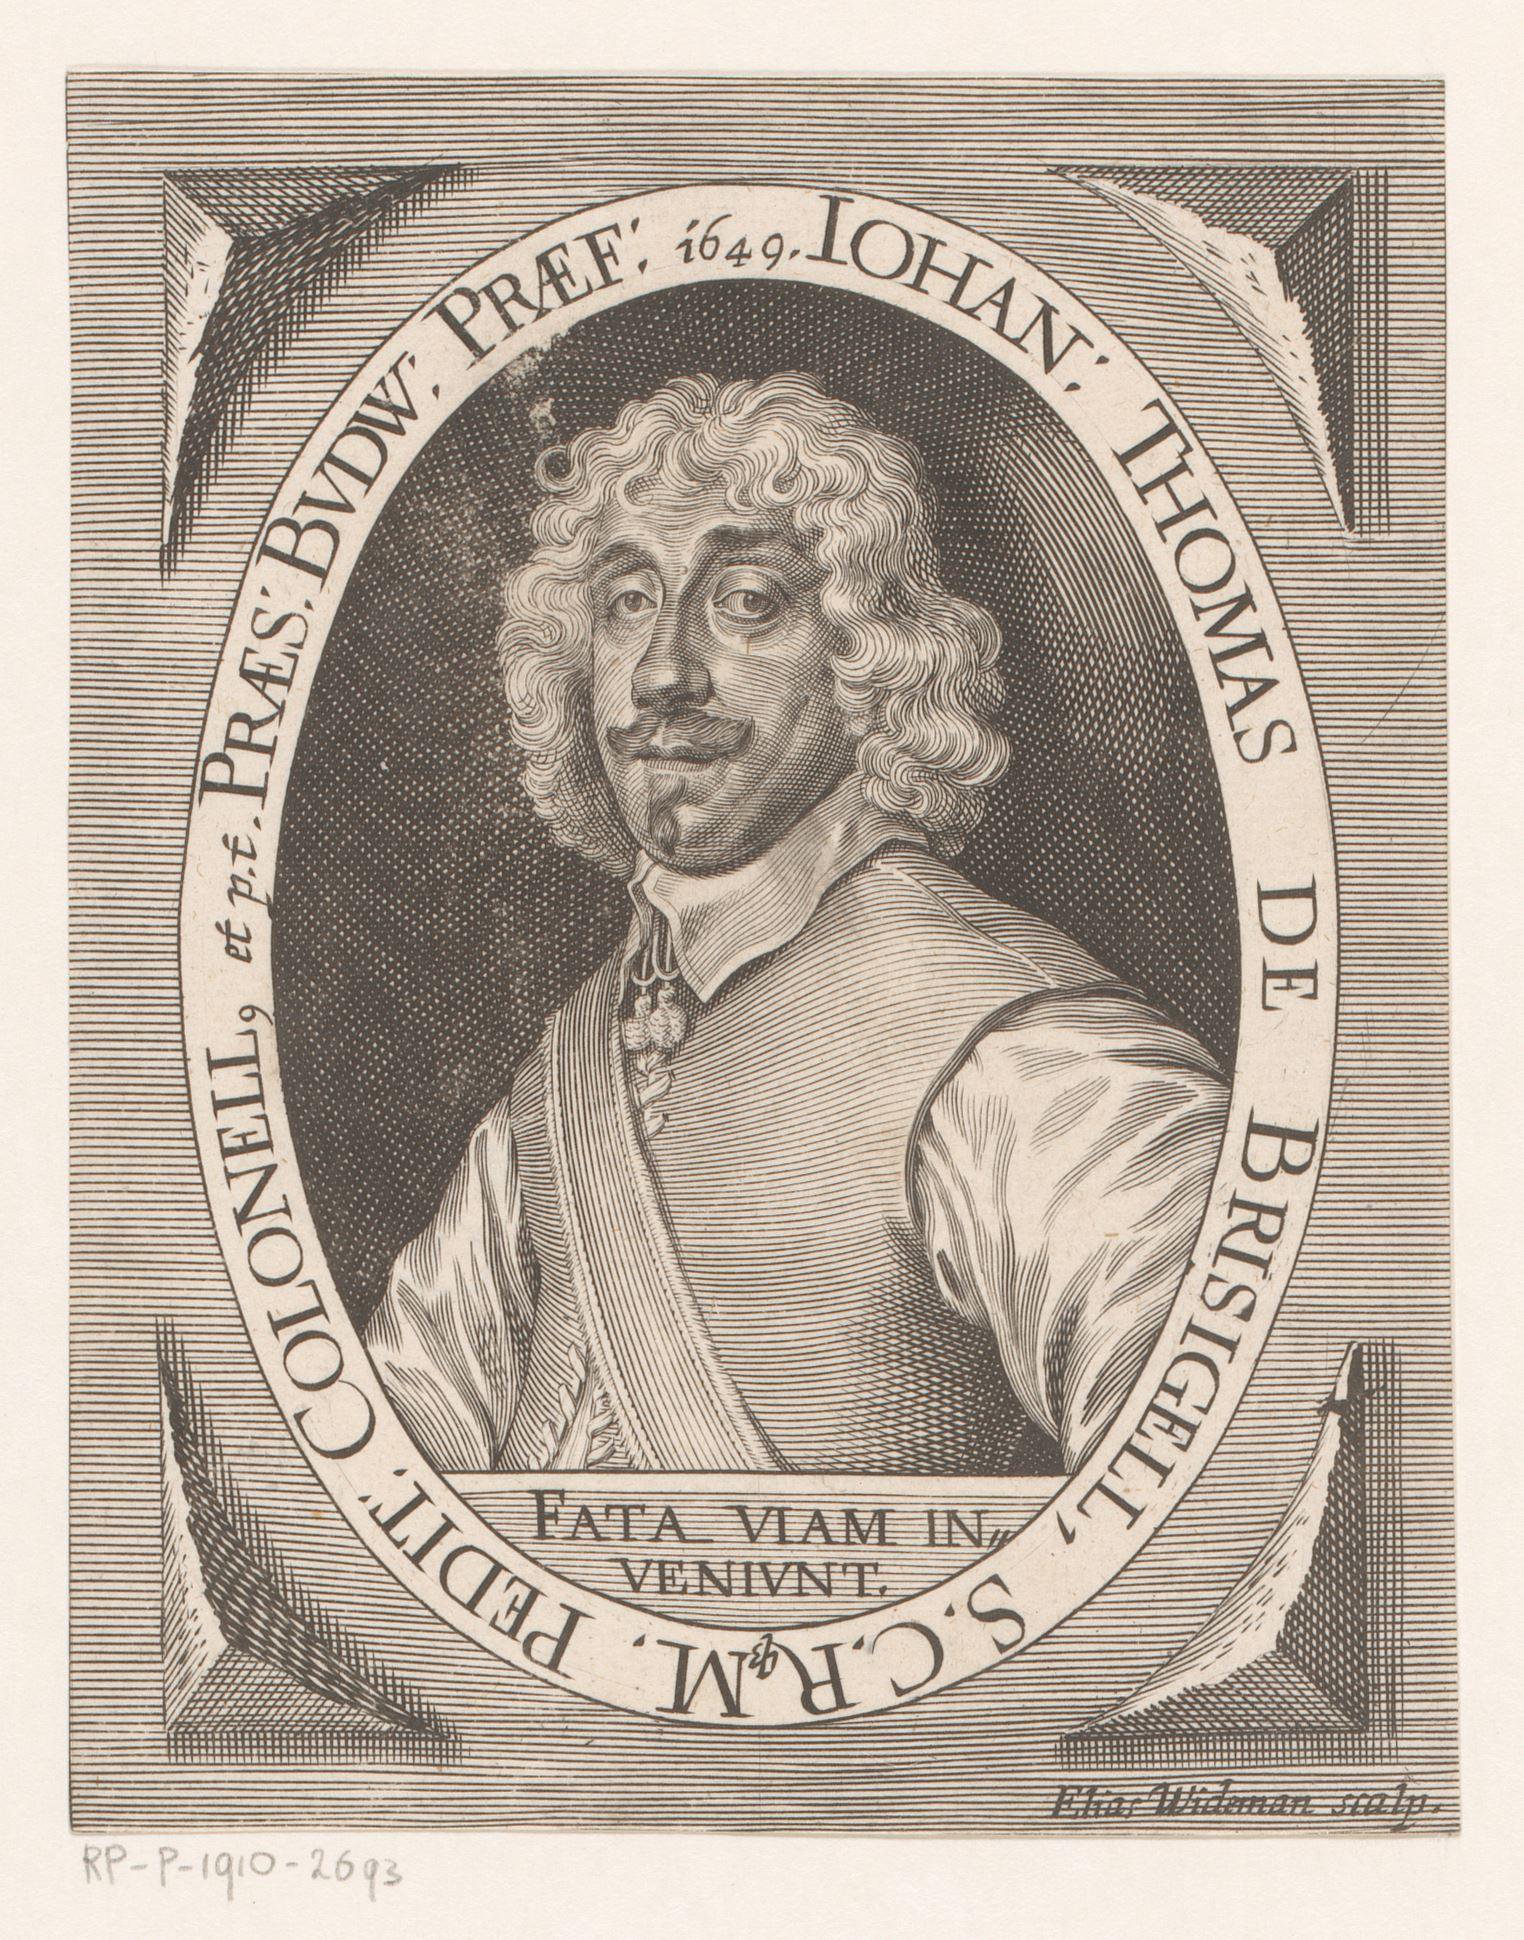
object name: print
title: Portret van Giovanni Tommaso Brisigello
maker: elias widemann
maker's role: print maker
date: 1649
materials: paper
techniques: engraving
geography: germany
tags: historical persons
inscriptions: collector's mark: Lugt 2228